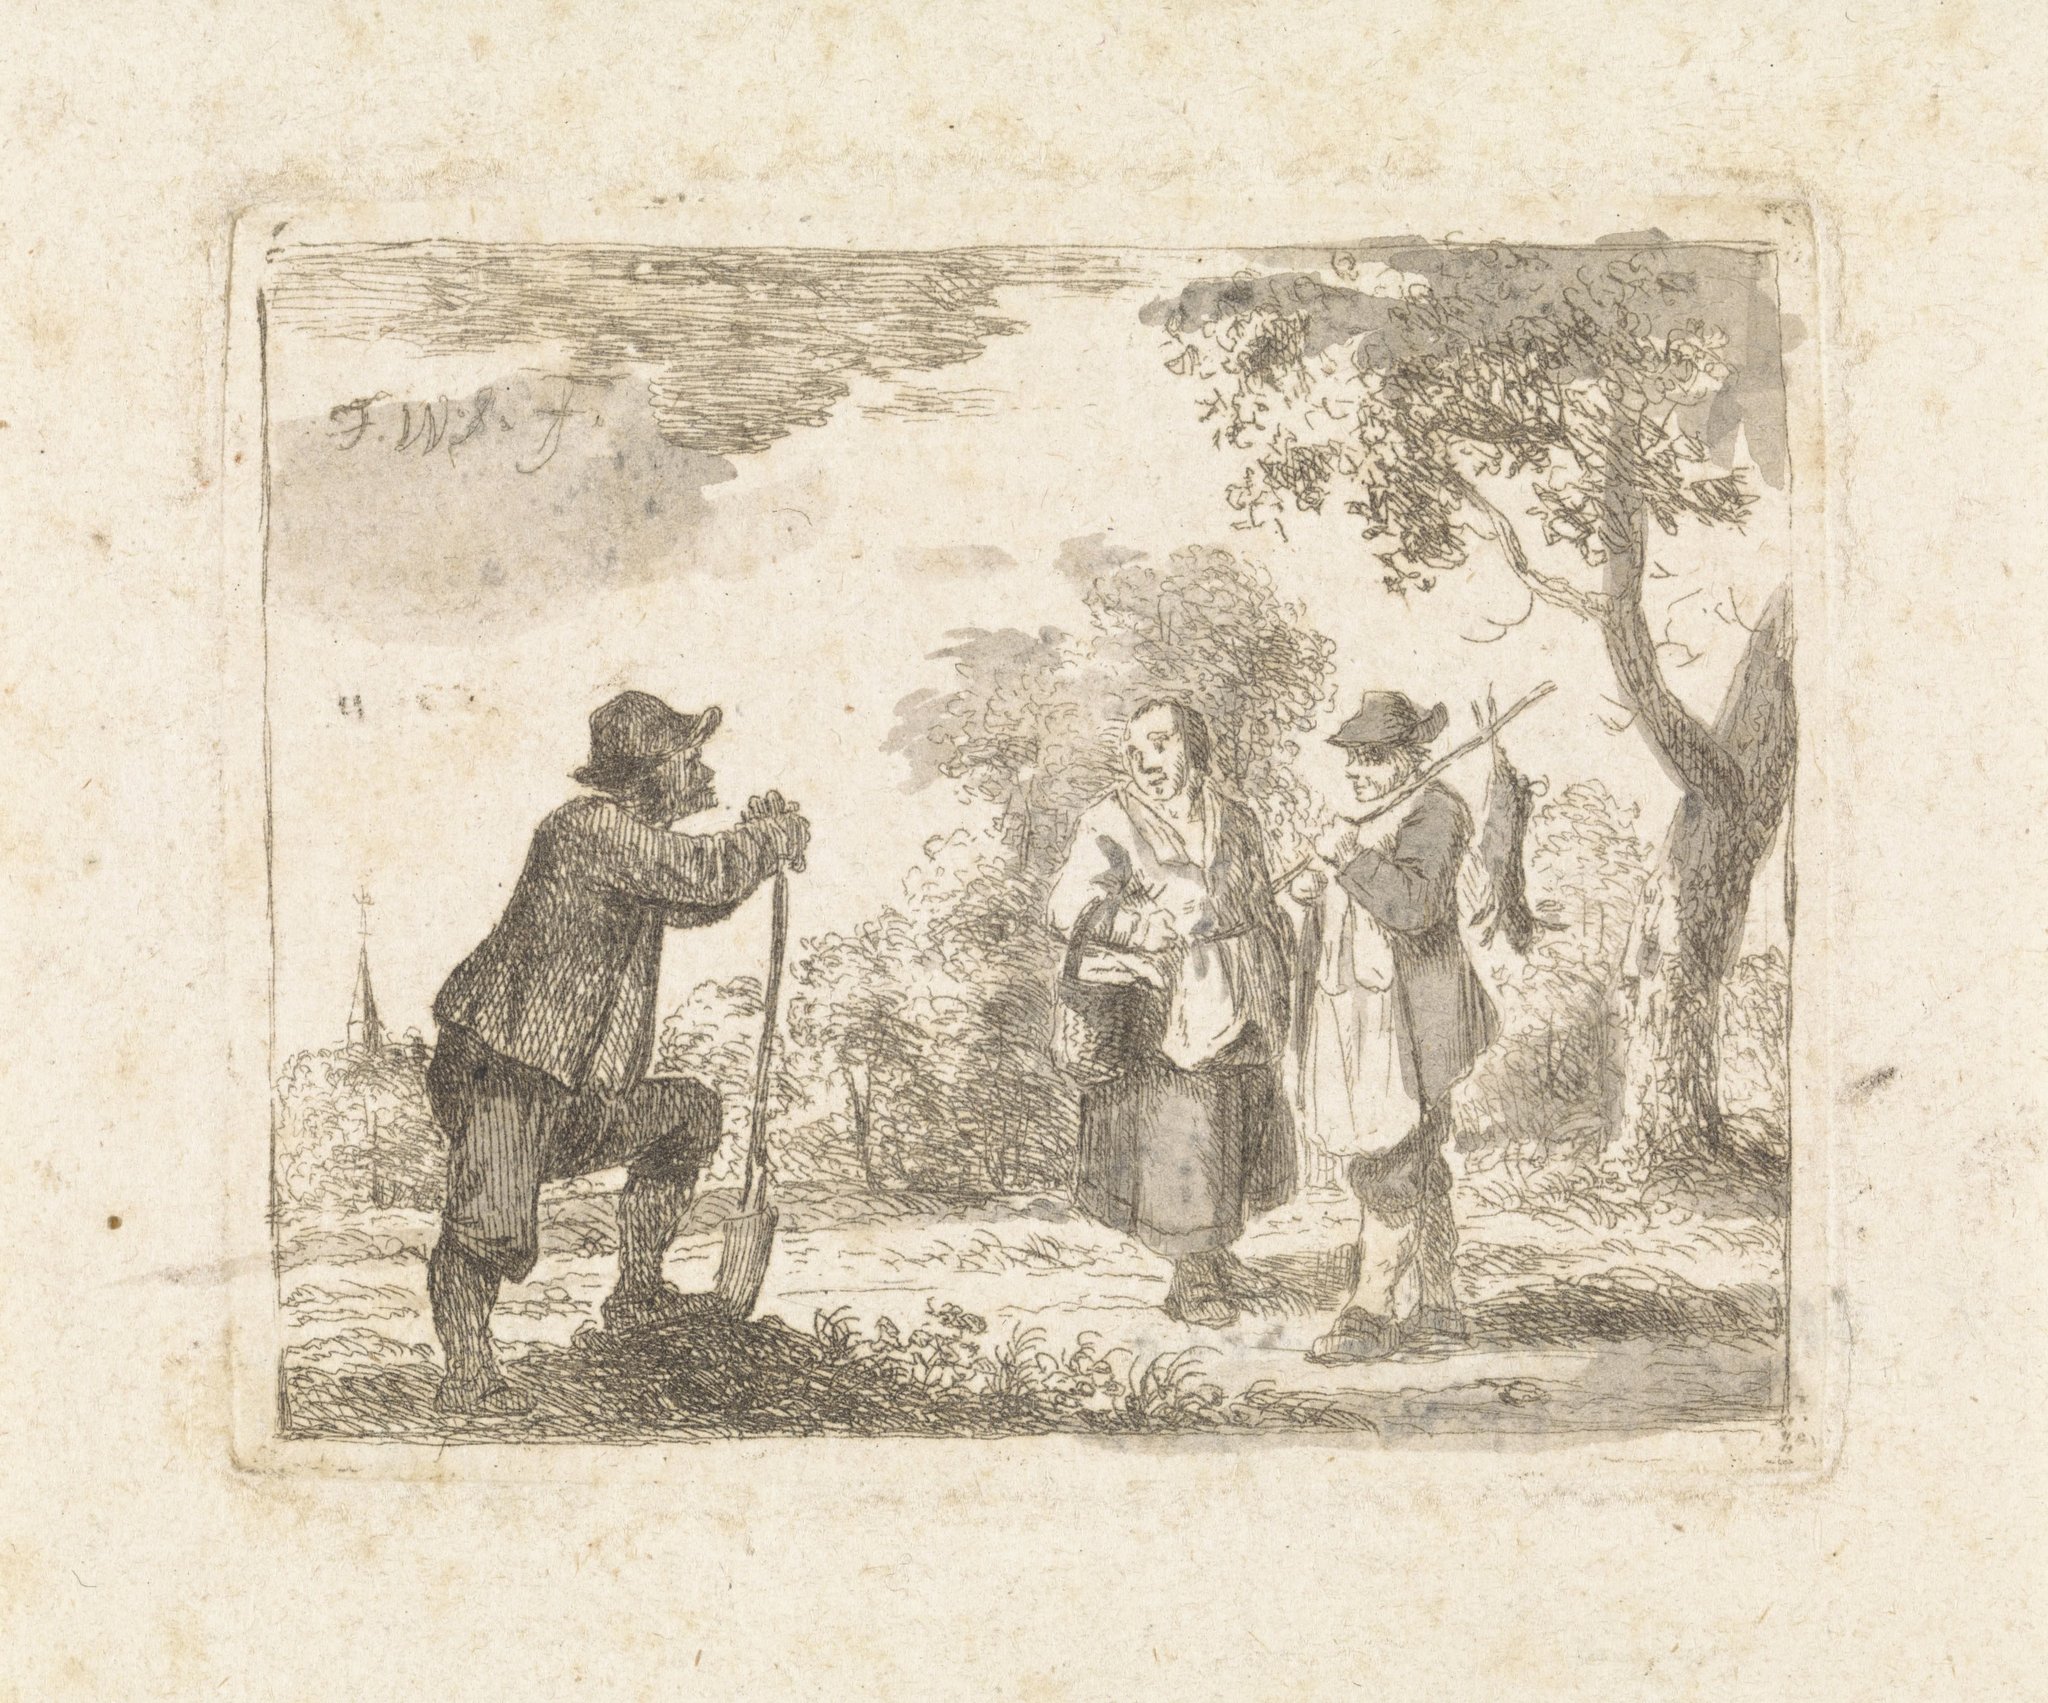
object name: print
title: Landschap met drie boeren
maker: théodore wynant stallenbergh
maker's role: print maker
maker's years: 1738-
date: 1748-1771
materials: paper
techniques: etching, hand coloring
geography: southern netherlands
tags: farmers, agricultural implements: spade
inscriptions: inscription: ‘F.W. Stallenberg’, collector's mark: Lugt 2228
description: Een boer, leunend op zijn spade, spreekt met een man en een vrouw, die op een afstandje staan. De vrouw heeft een mand aan haar arm, de man heeft een haas aan een stok.